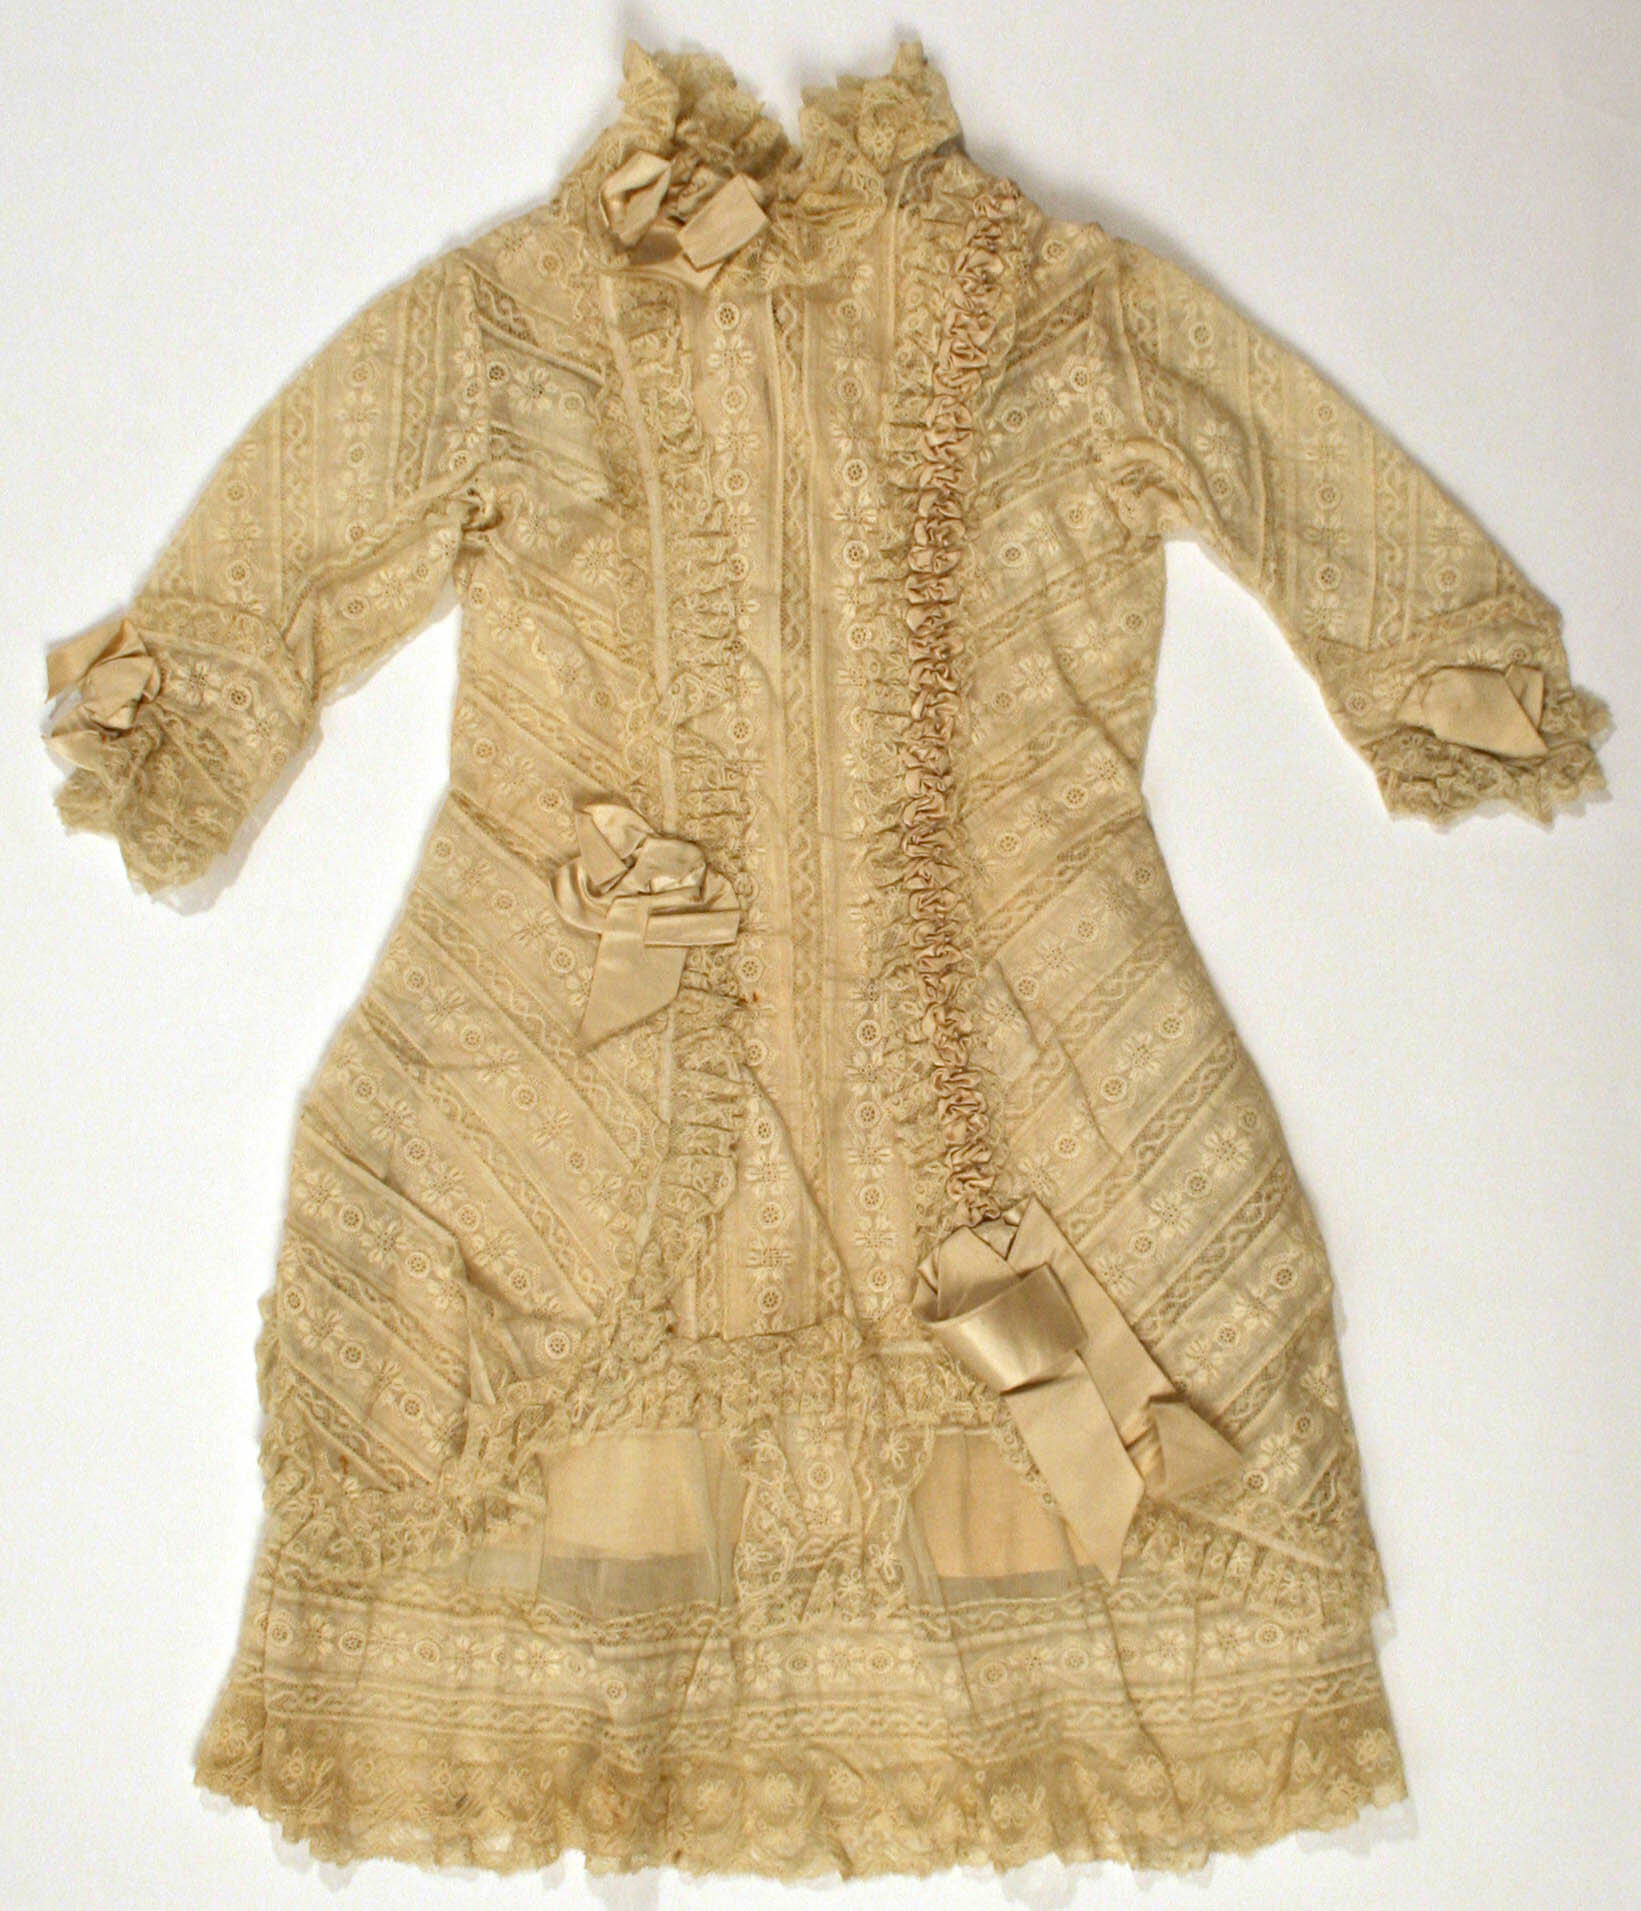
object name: dress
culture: american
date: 1880-1889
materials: cotton